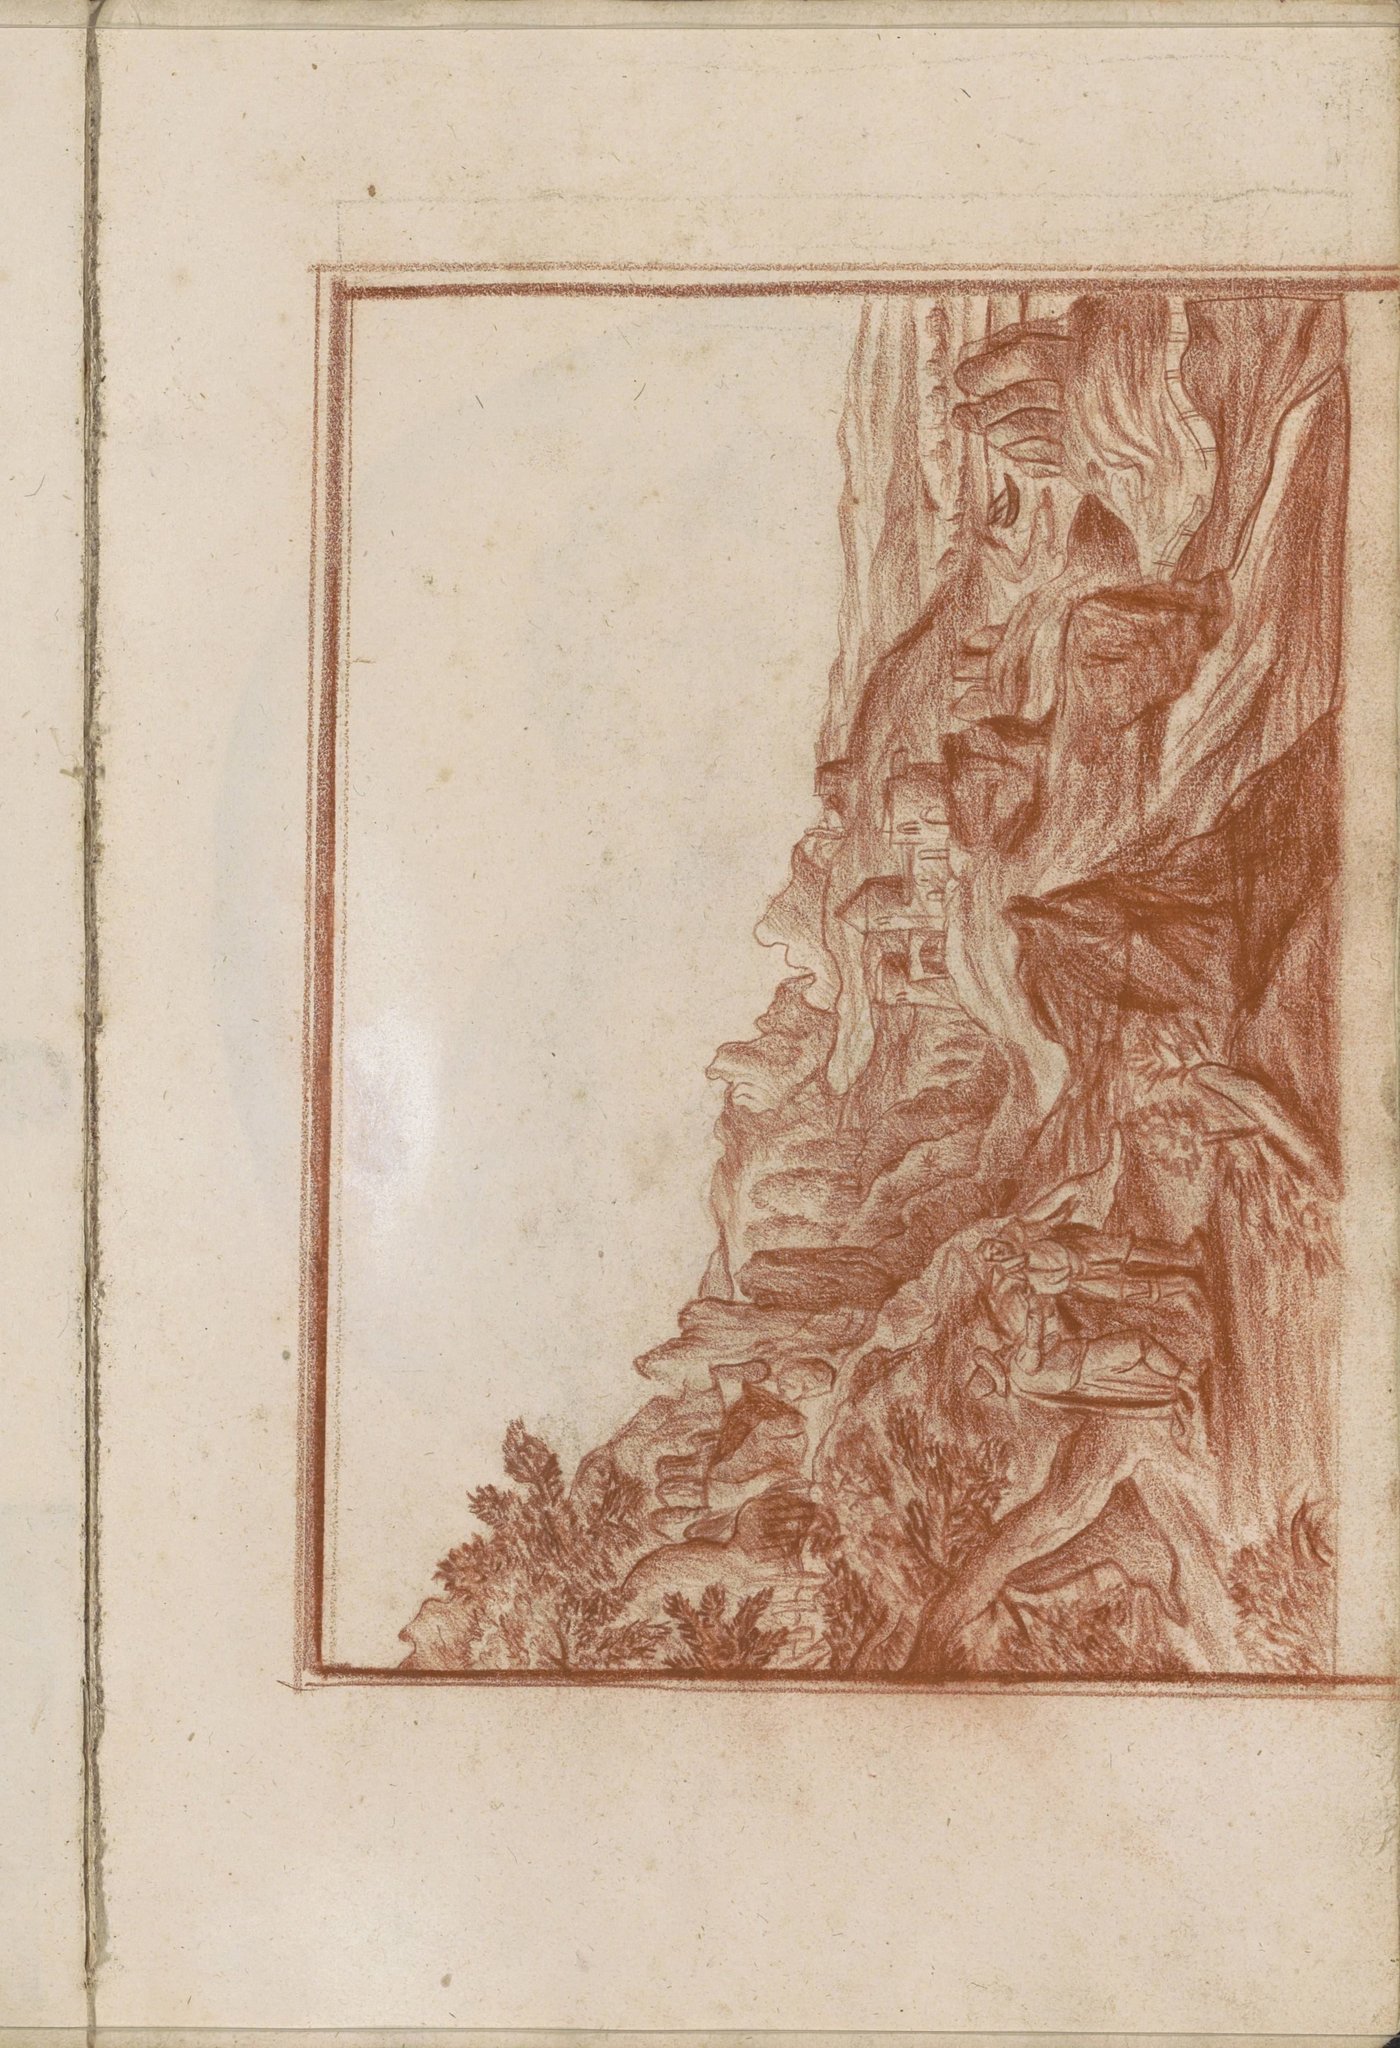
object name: sketchbook leaf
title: Twee reizigers in een berglandschap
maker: hendrick van beaumont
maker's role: draughtsman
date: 1696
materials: chalk, paper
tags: mountains (+ landscape with figures, staffage)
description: Blad 77 recto uit een schetsboek met 91 bladen.